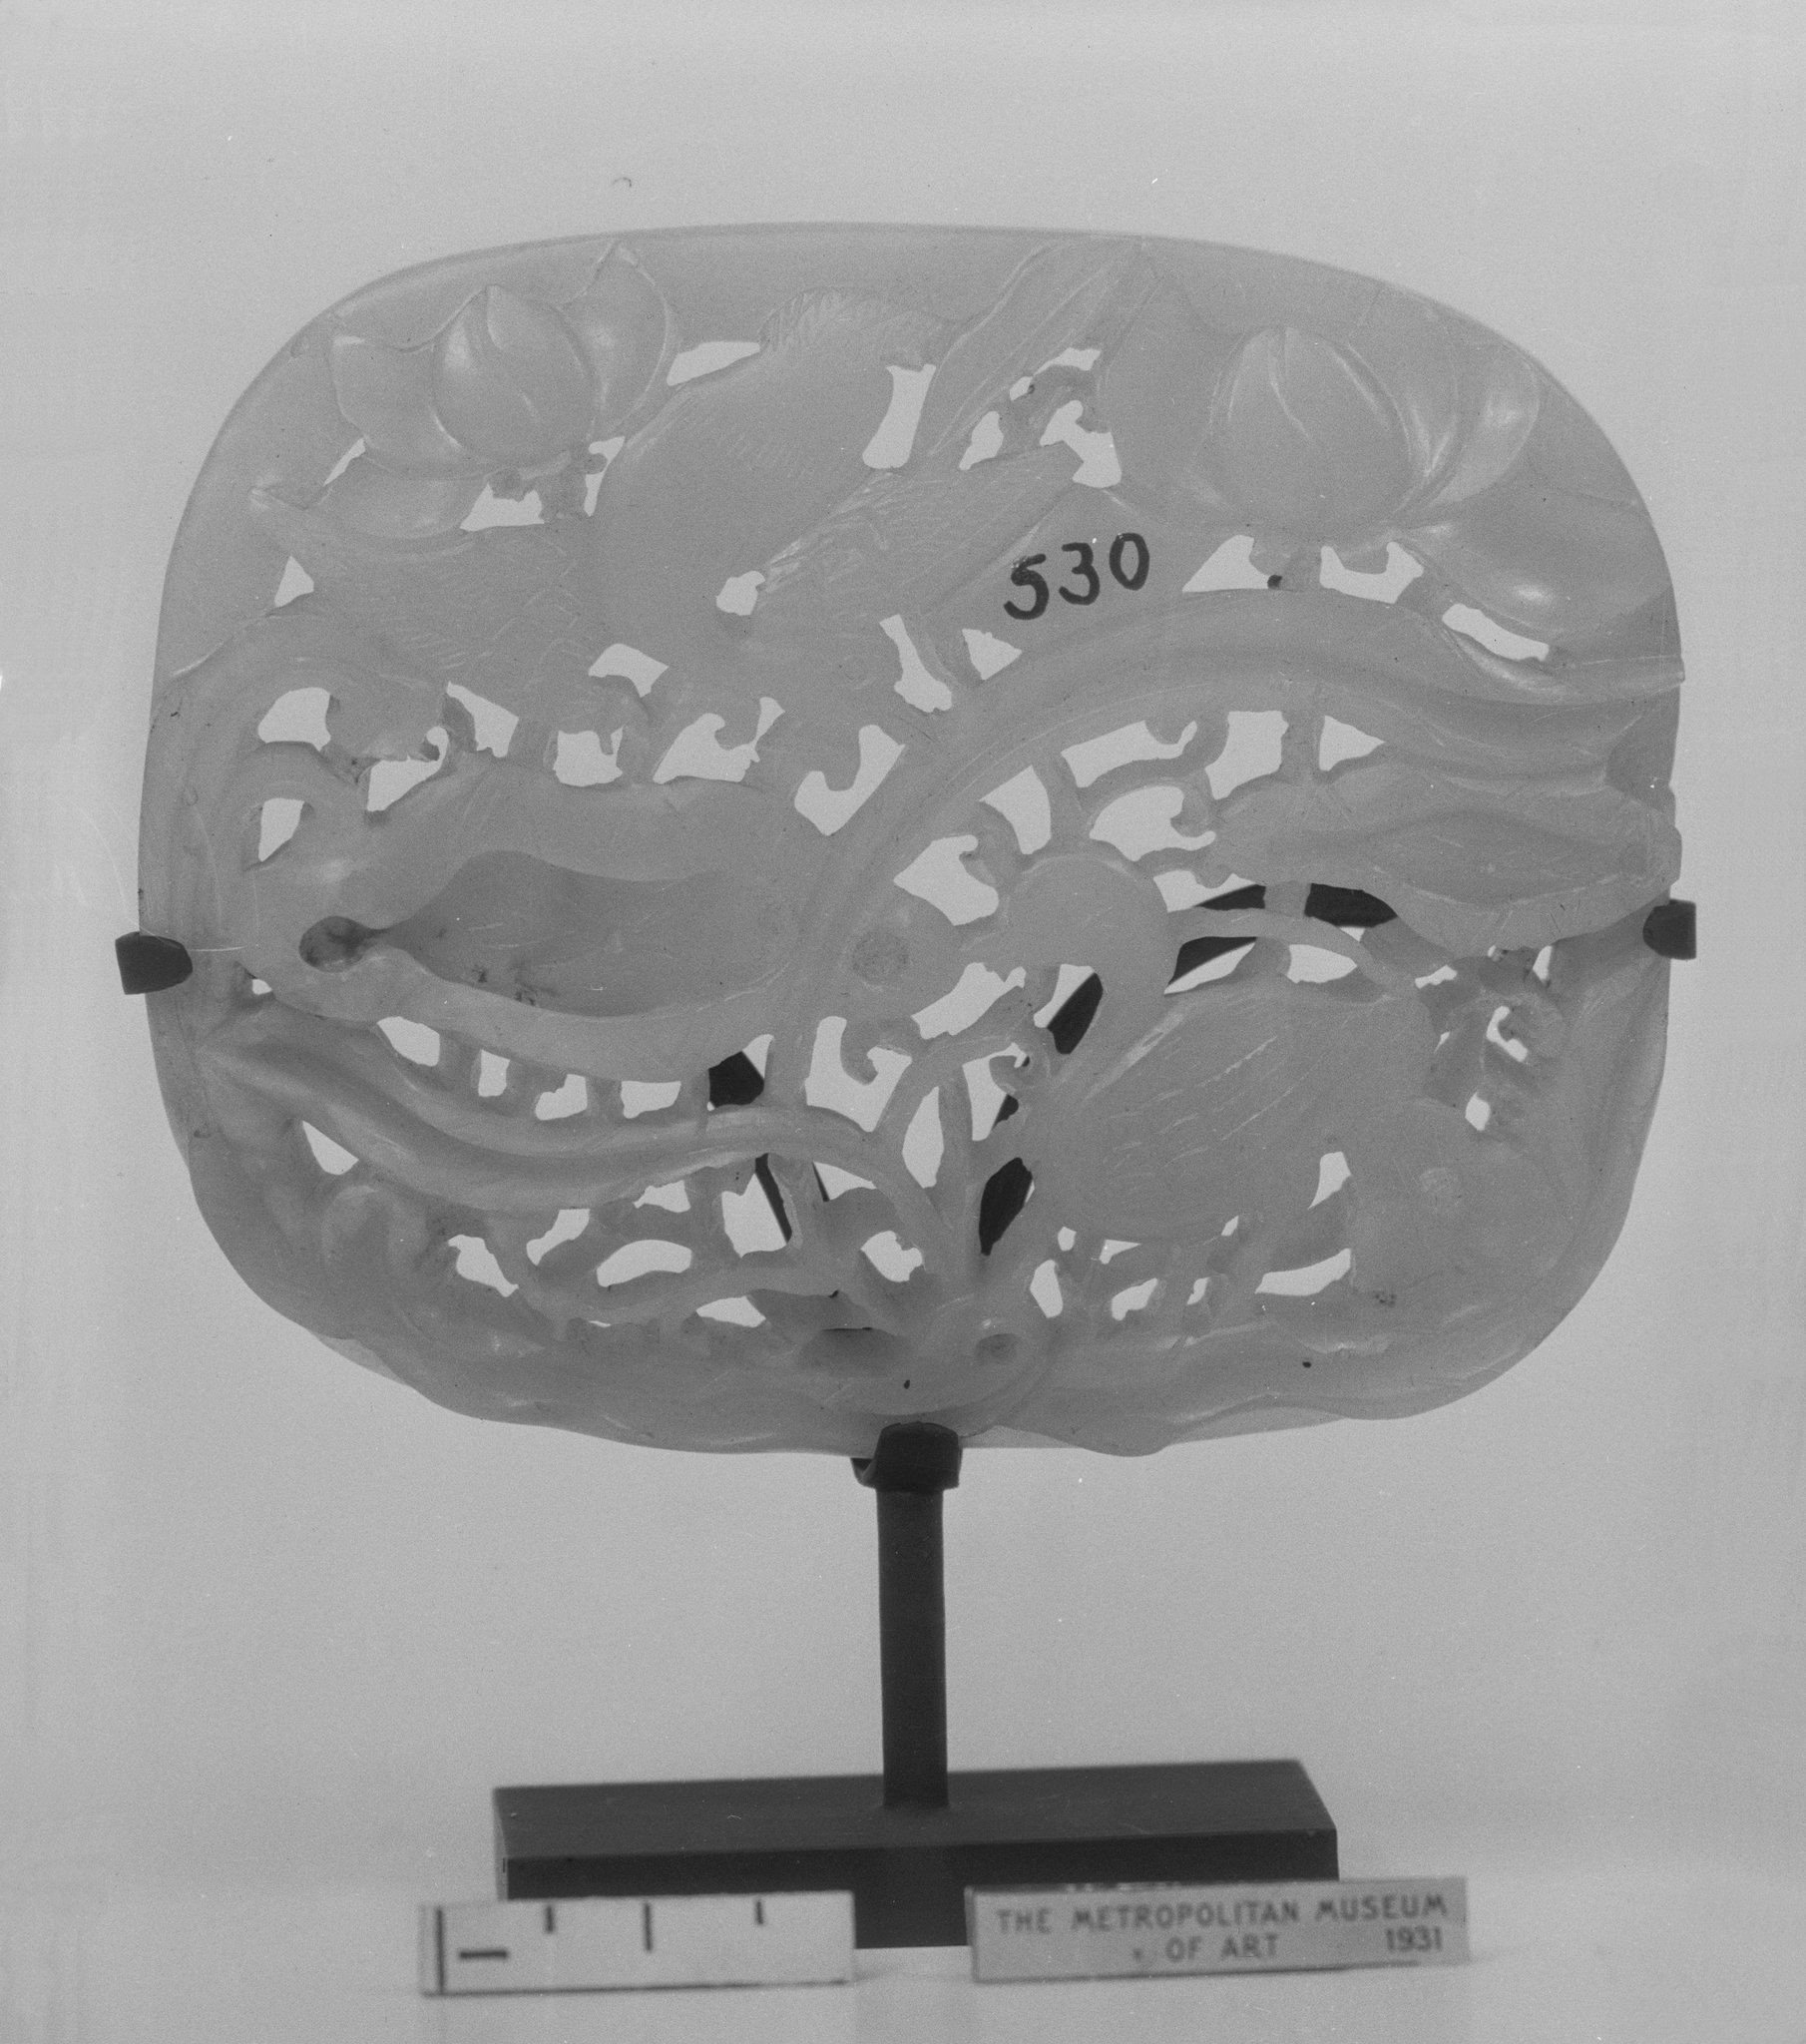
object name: plaque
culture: chinese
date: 1736-1795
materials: jade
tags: birds,flowers